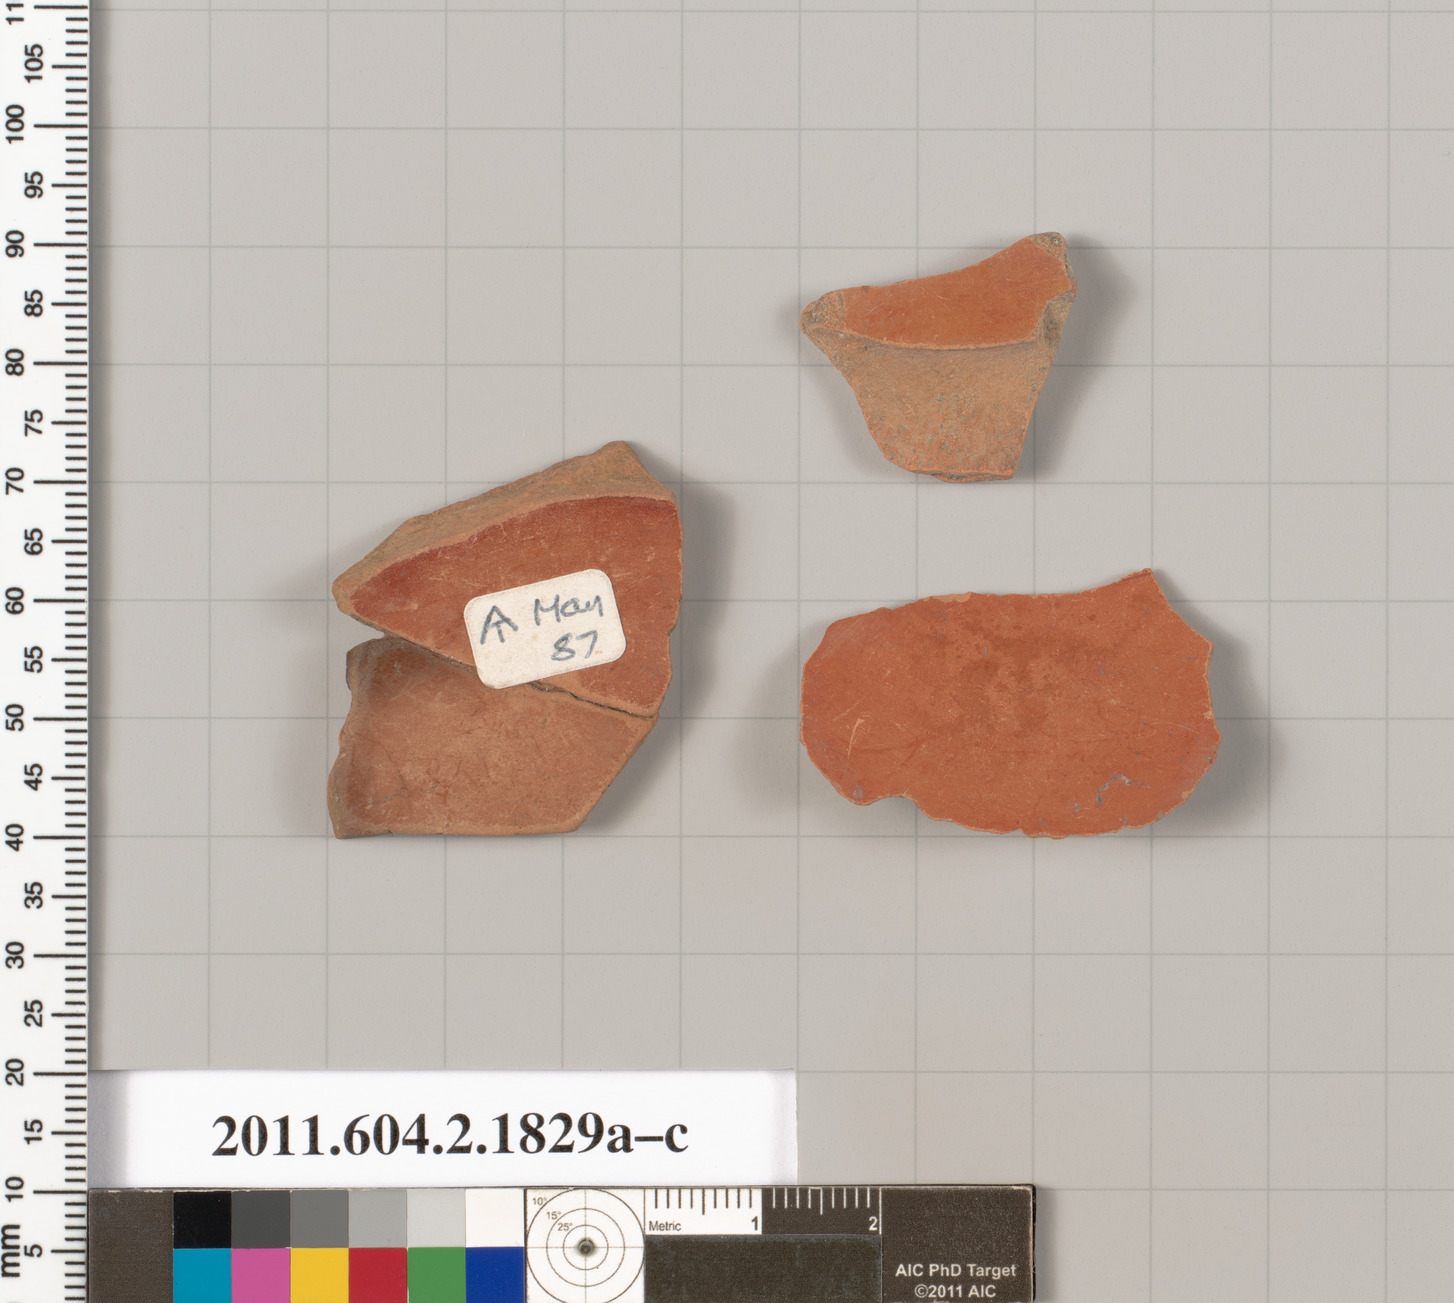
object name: skyphos fragment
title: Terracotta fragments of skyphoi (deep drinking cups)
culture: greek, attic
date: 450-401 BCE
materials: terracotta